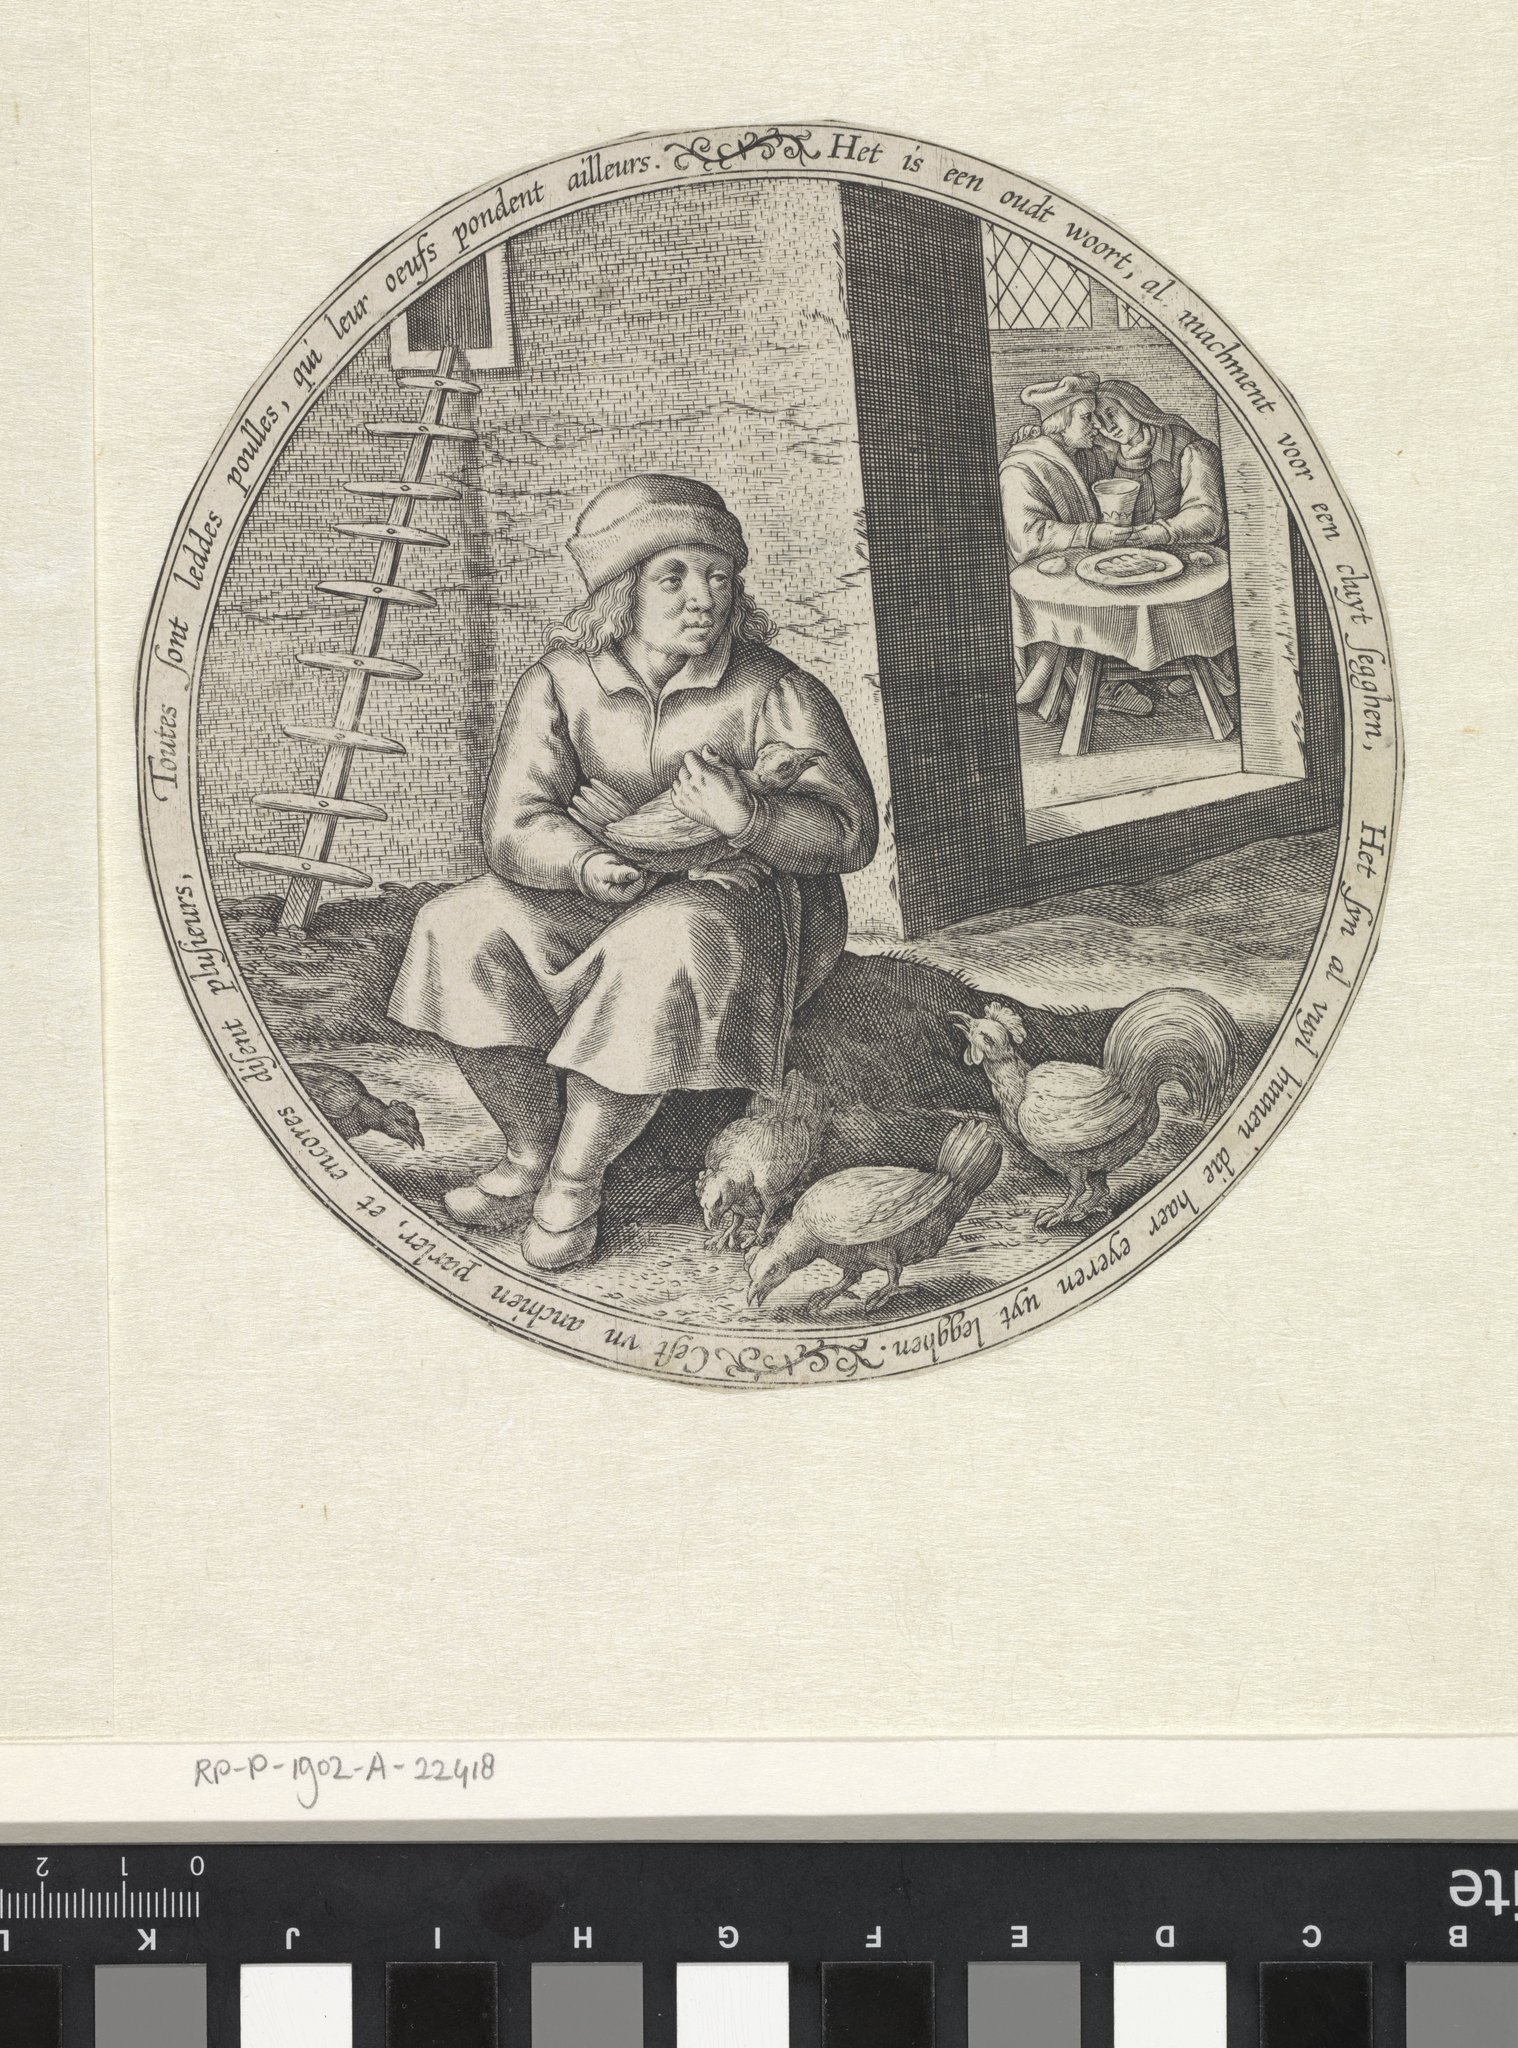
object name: print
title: Medaillons met dubbelzinnige randschriften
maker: Anonymous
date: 1550-1610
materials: paper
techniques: engraving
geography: southern netherlands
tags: hen-pecked husband, sexual abuses of monks, fowl (cock, hen, chicken, etc.), relations between the sexes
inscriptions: collector's mark: Lugt 2228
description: Een man houdt een hen vast en controleert of zij een ei zal gaan leggen. Rechts op de achtergrond is door een openstaande deur een geestelijke te zien, die een vrouw liefkoost. In het randschrift een dubbelzinnige tekst in het Nederlands en het Frans: Het is een oudt woort, al machment voor een cluyt segghen, Het syn al vuyl hinnen die haer eyeren uyt legghen.